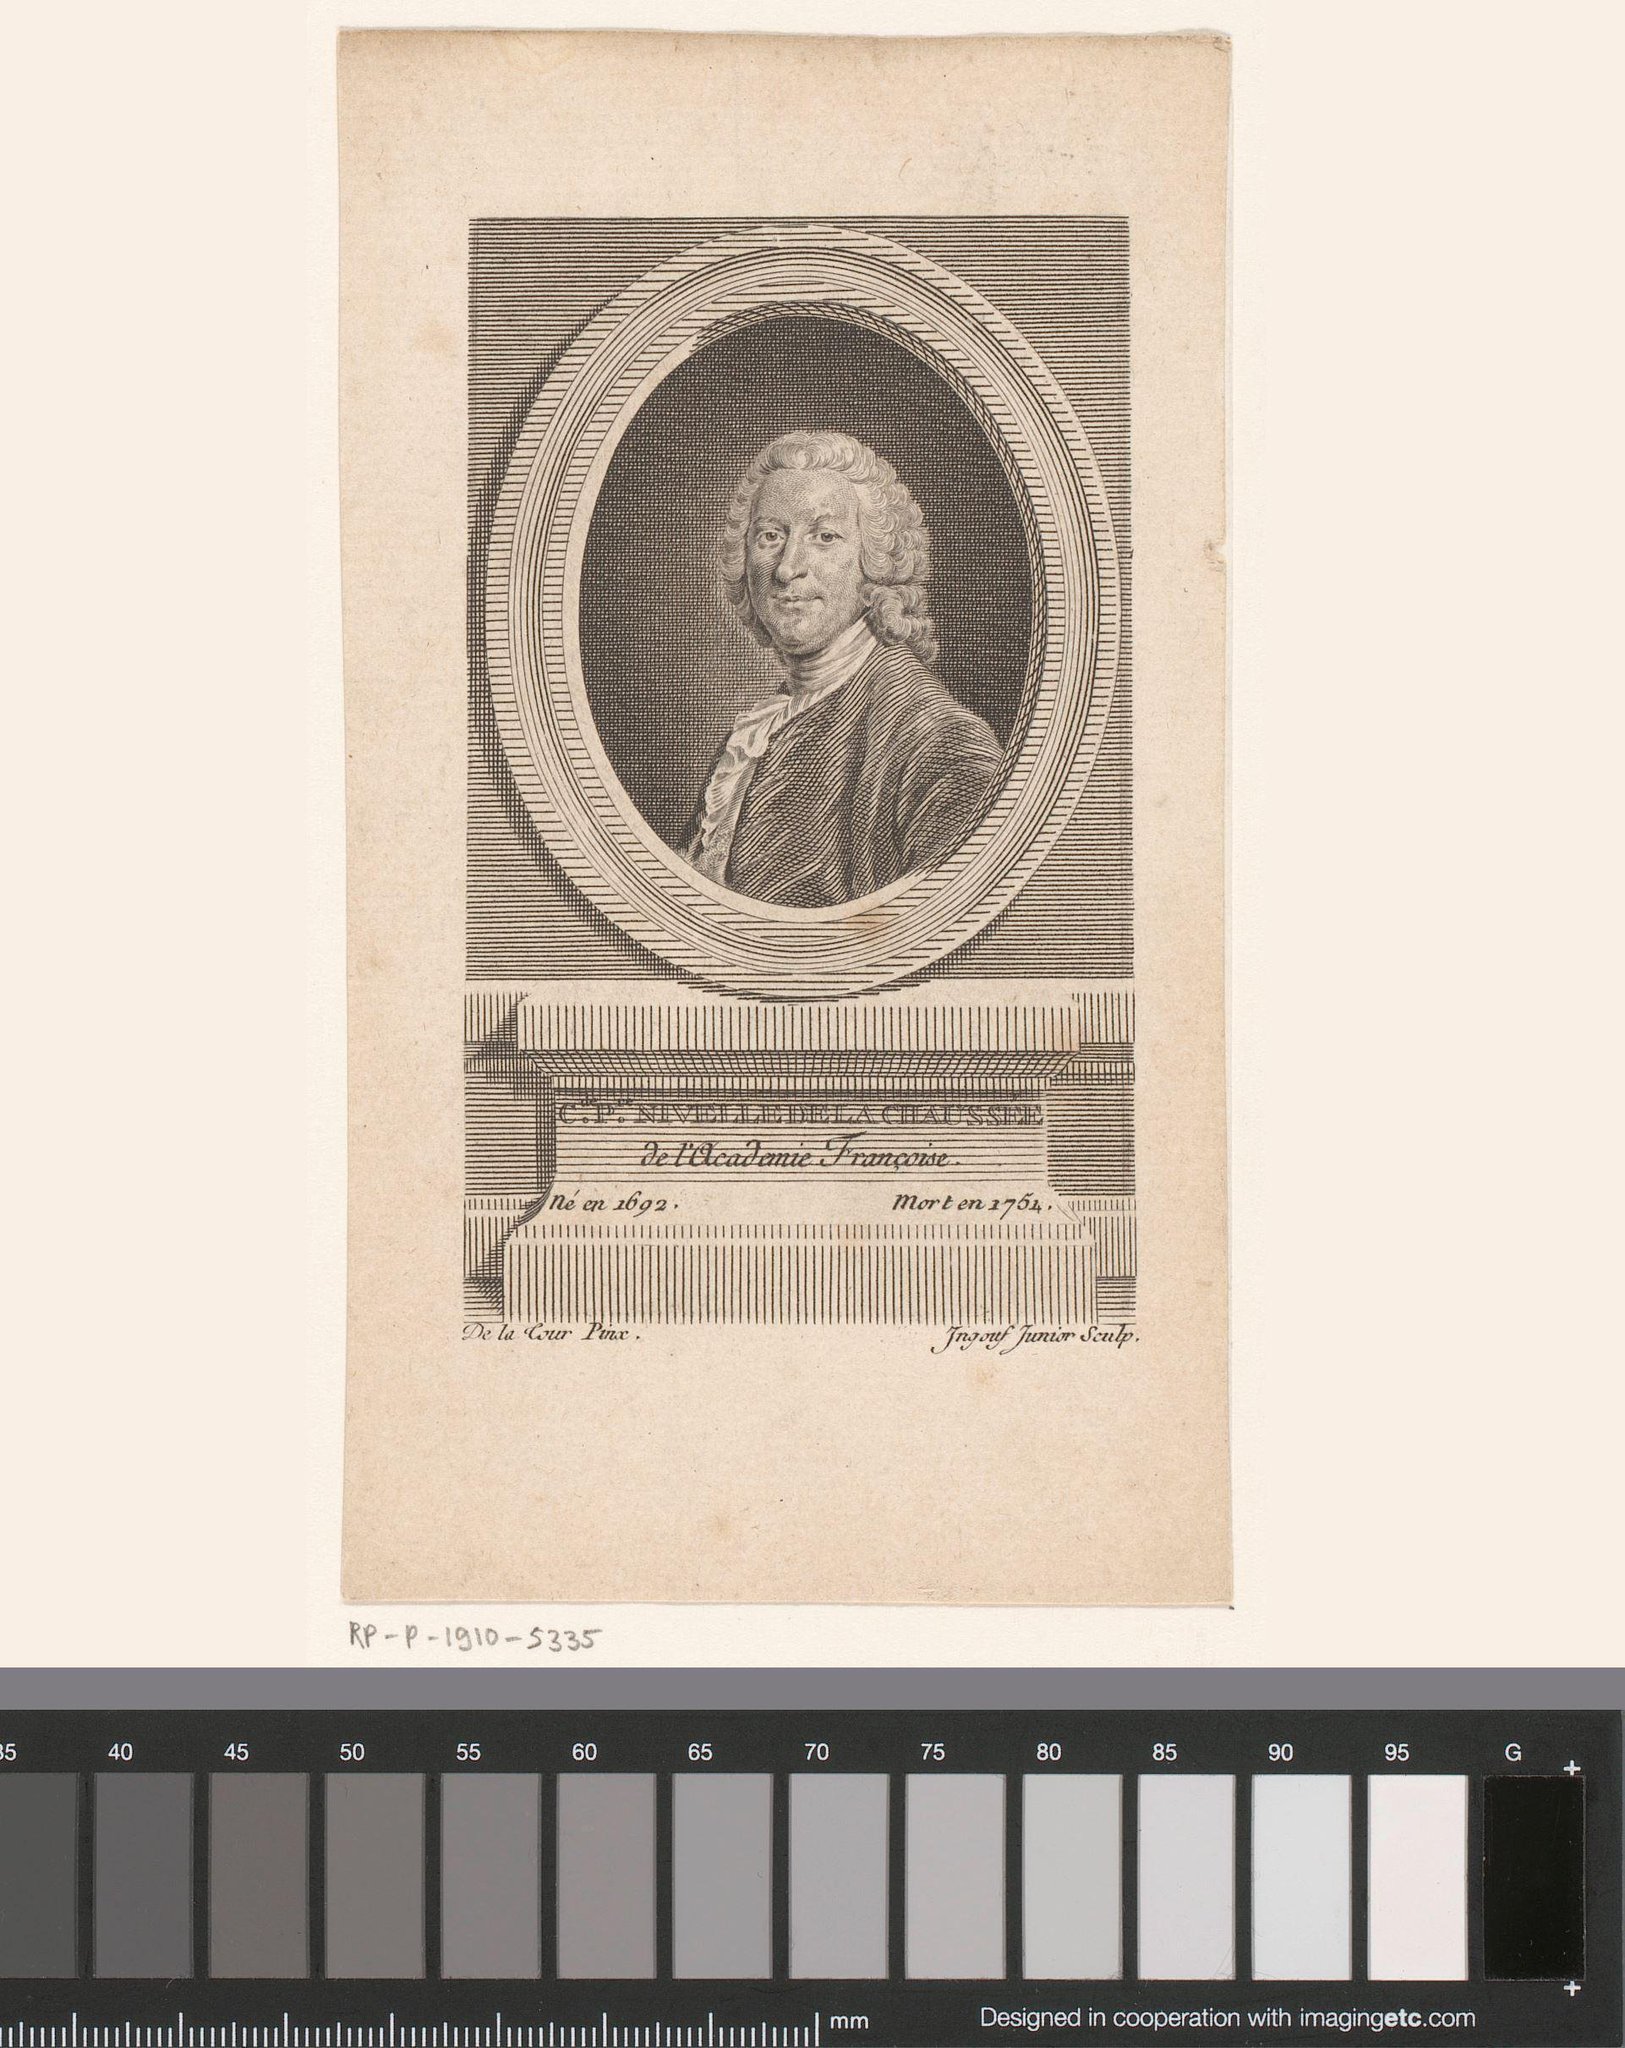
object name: print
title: Portret van Pierre-Claude Nivelle de La Chaussée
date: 1778-1787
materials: paper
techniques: engraving, etching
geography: paris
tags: paris, historical persons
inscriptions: collector's mark: Lugt 2228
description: Prent uit: Annales poétiques, ou Almanach des Muses. Parijs: Delalain, 1778-1787, dl. 38.